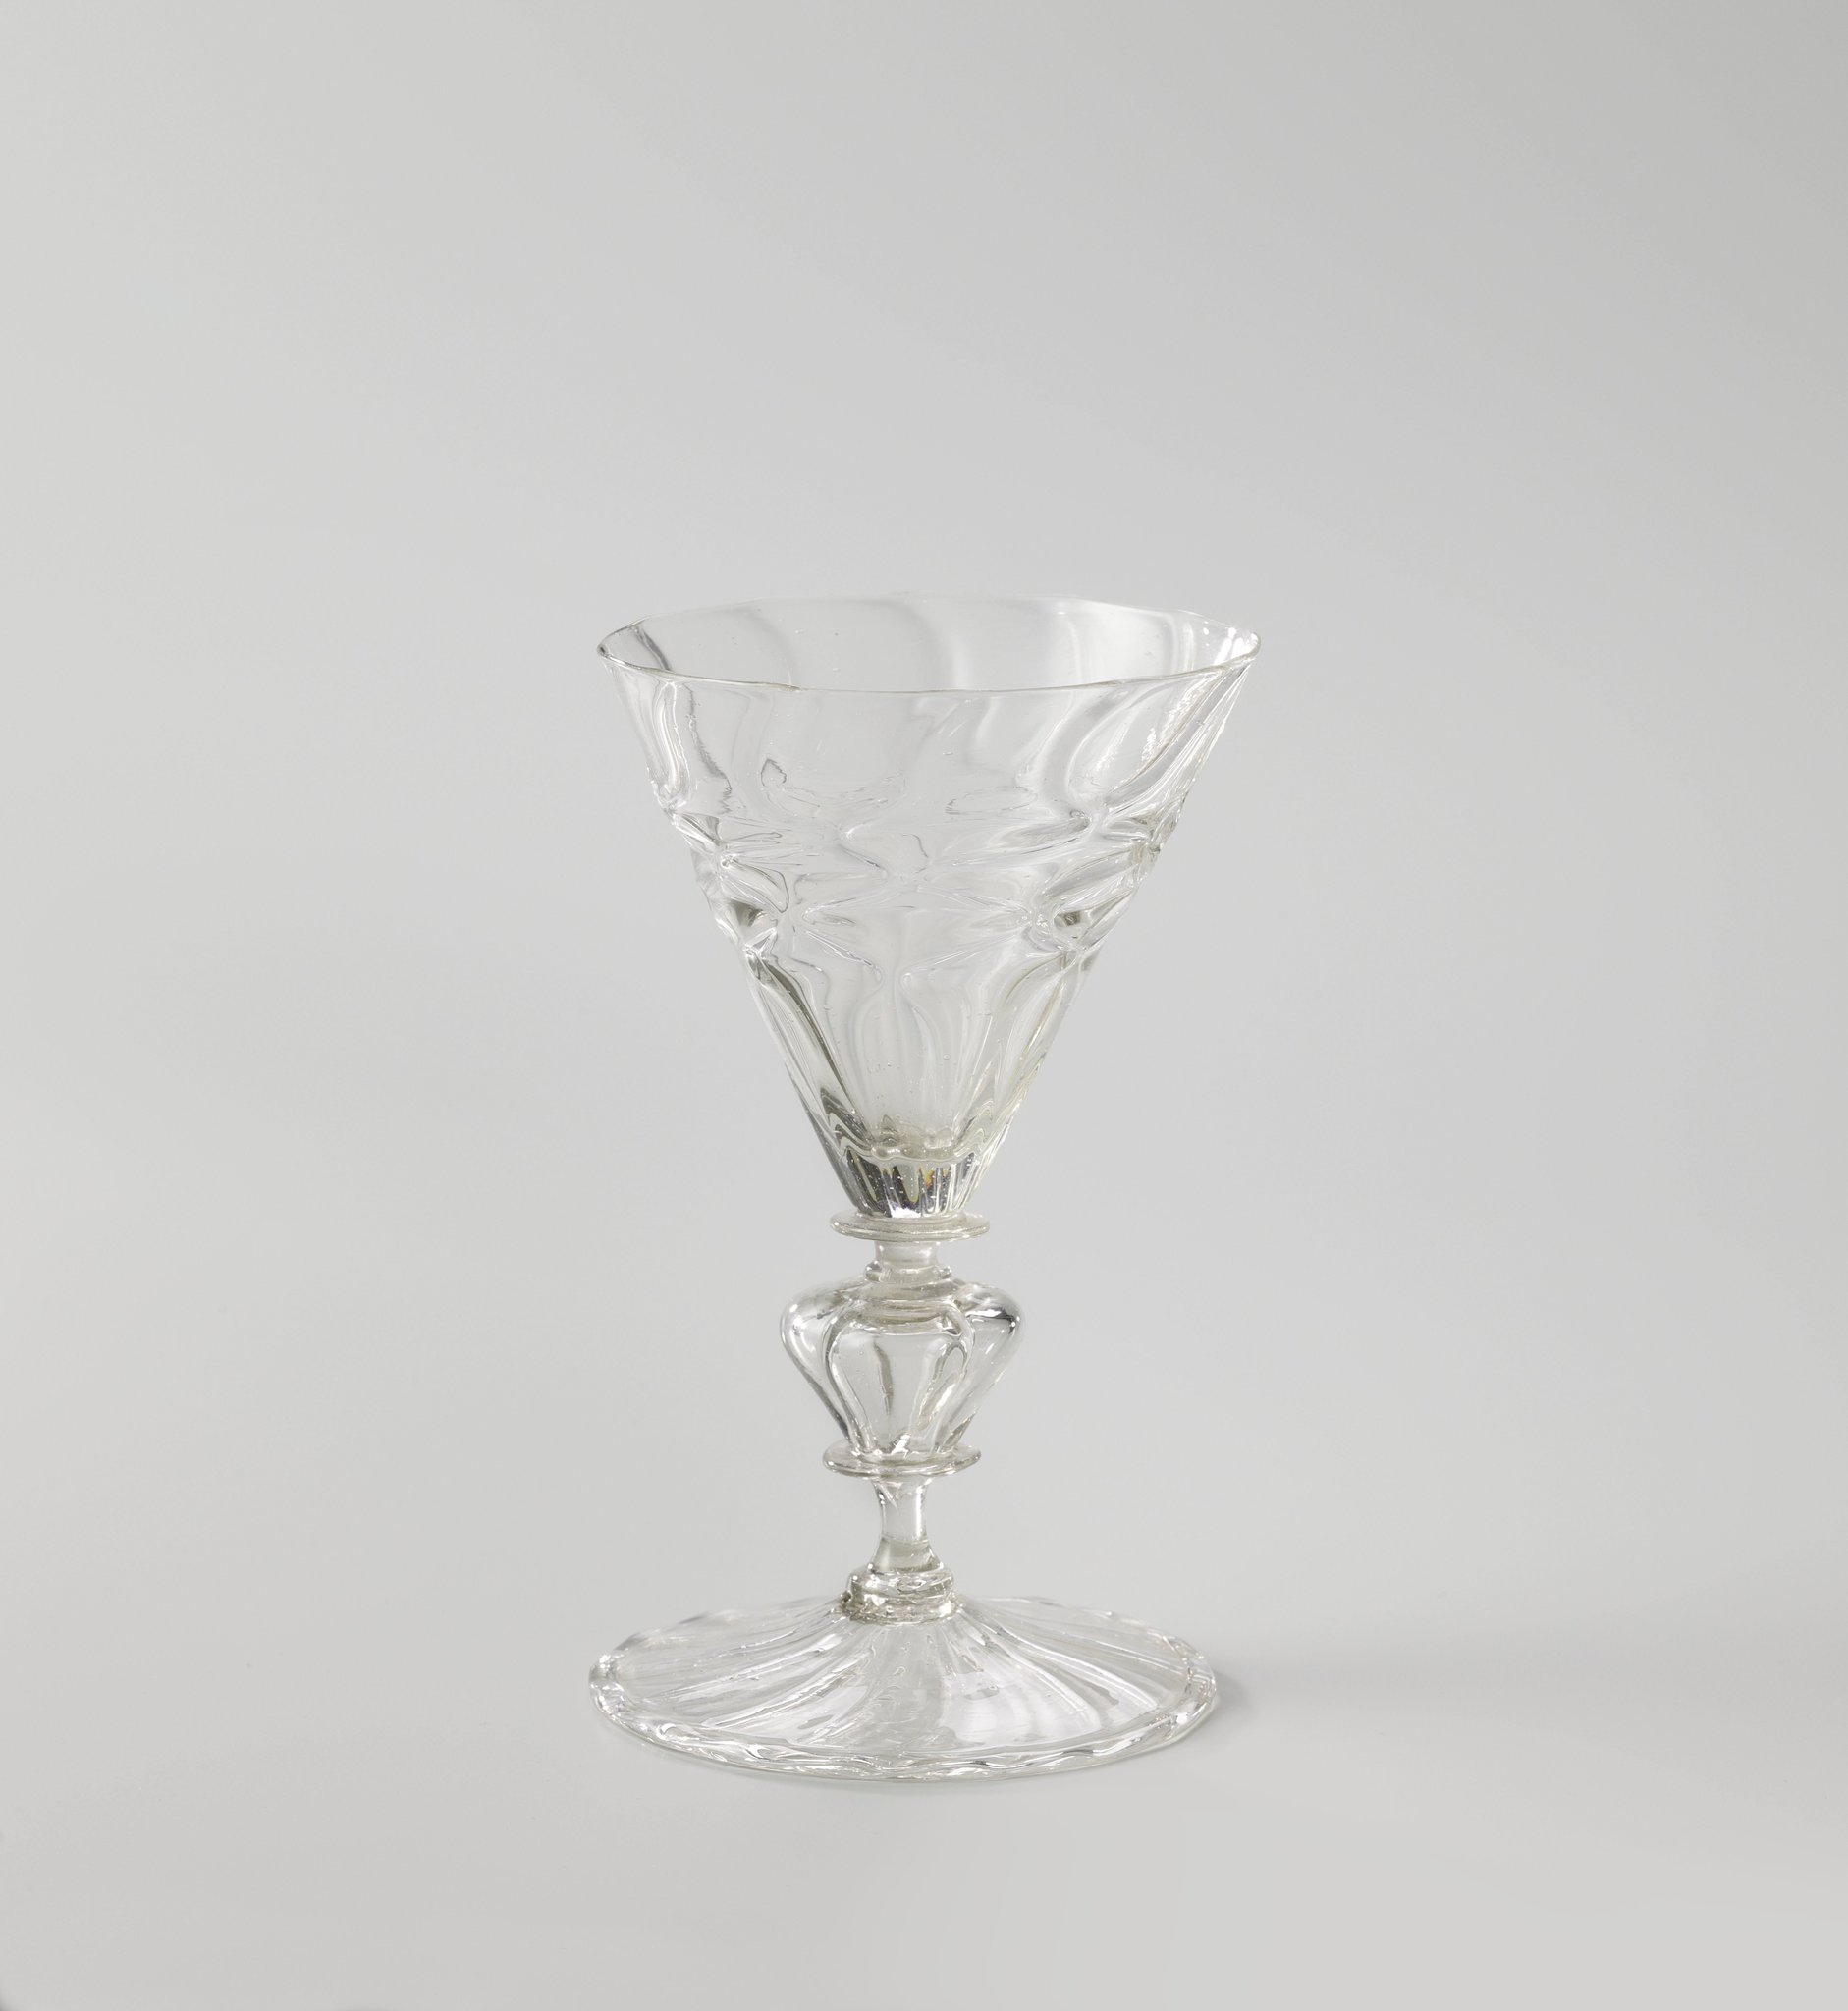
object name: goblet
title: Kelkglas met trechtervormige kelk, optisch geblazen met geknepen ruiten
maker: Anonymous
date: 1650-1700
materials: glass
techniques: façon de venise, glassblowing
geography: low countries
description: Wine glass. Netherlands, façon de Venise, c. 1650-1700. A.J. Enschedé bequest, 1896.